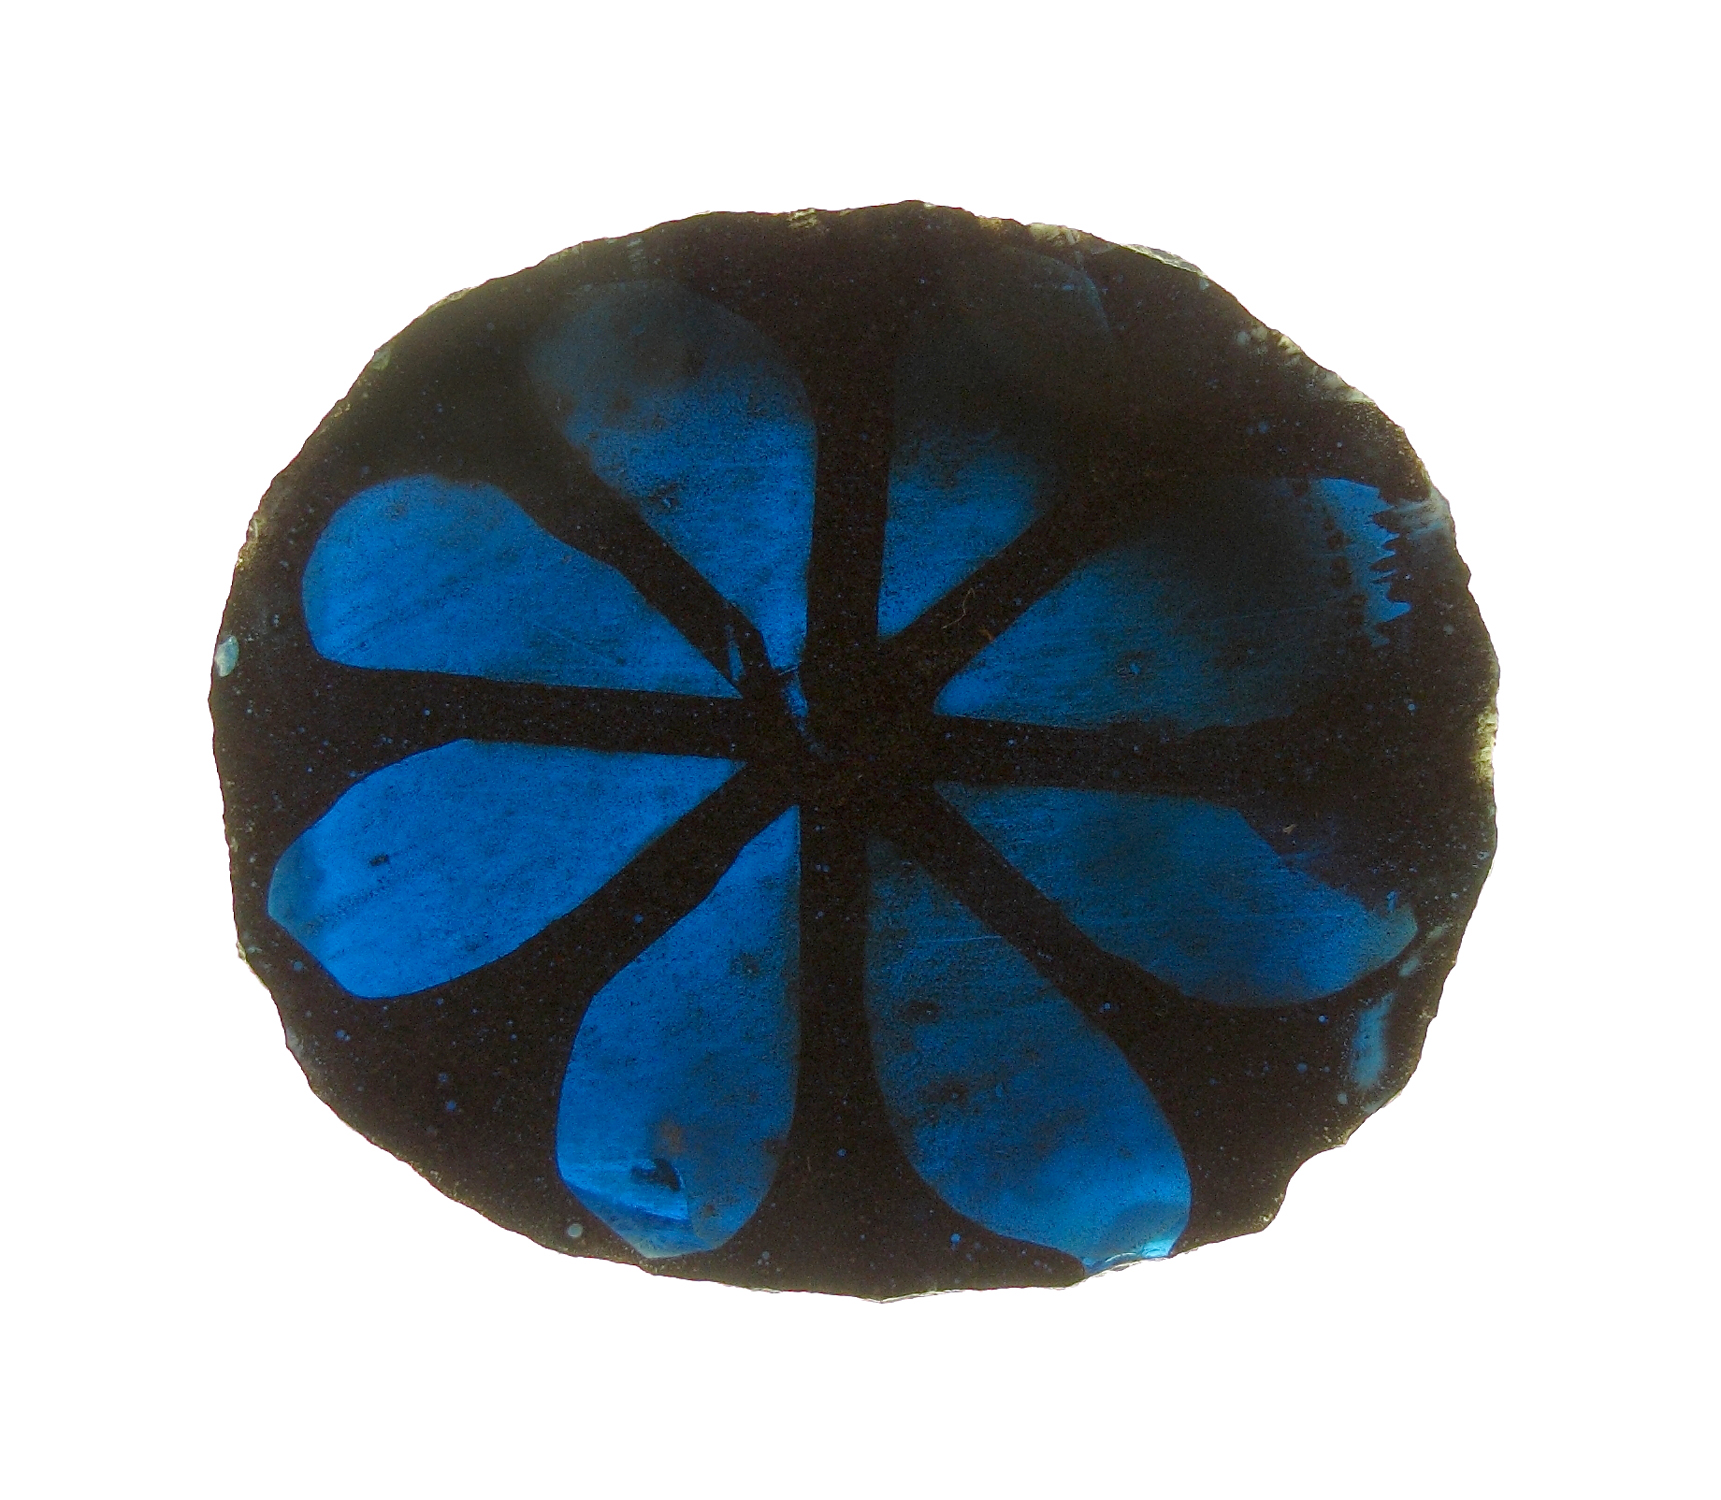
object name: fragment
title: Glass Fragment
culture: european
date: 1201-1400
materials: glass, metal